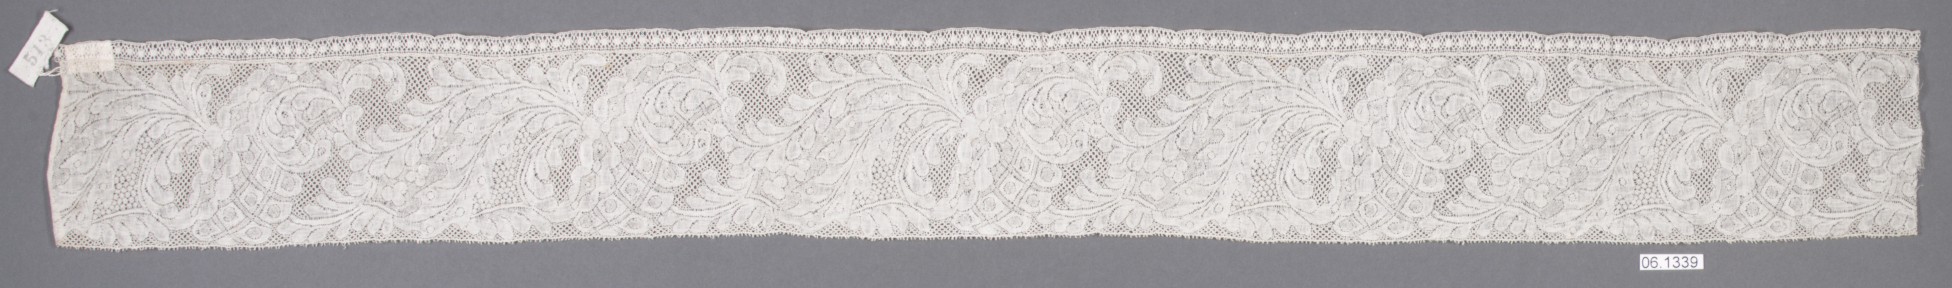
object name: strip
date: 1701-1733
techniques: lace